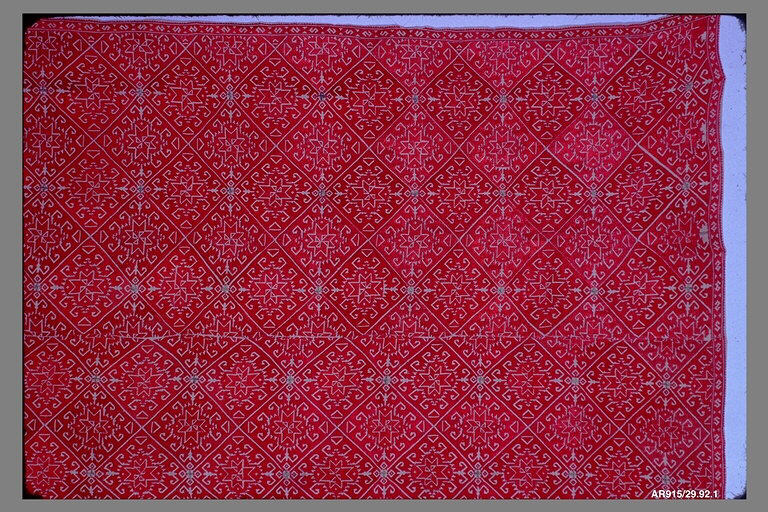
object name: bed curtain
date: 1701-1800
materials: linen, silk